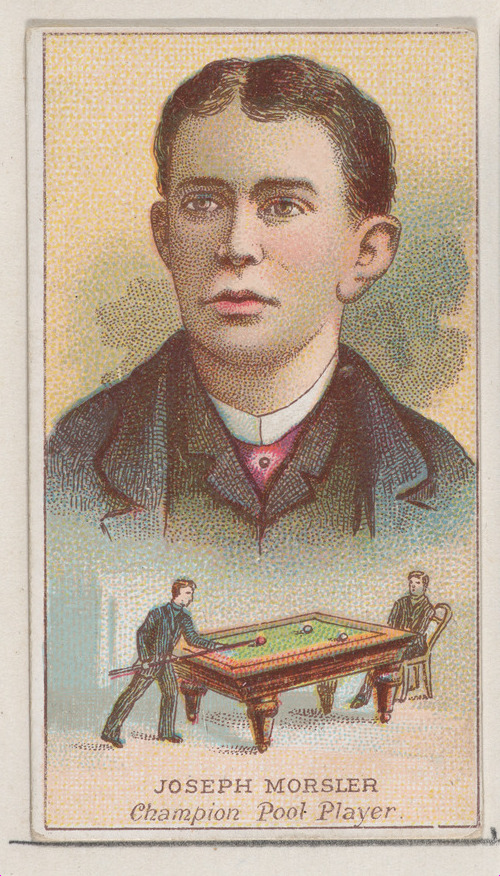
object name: print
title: Joseph Morsler, Champion Pool Player, from the Champions of Games and Sports series (N184, Type 2) issued by W.S. Kimball & Co.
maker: w.s. kimball & co.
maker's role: publisher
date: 1887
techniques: color lithograph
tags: men,billiards,athletes